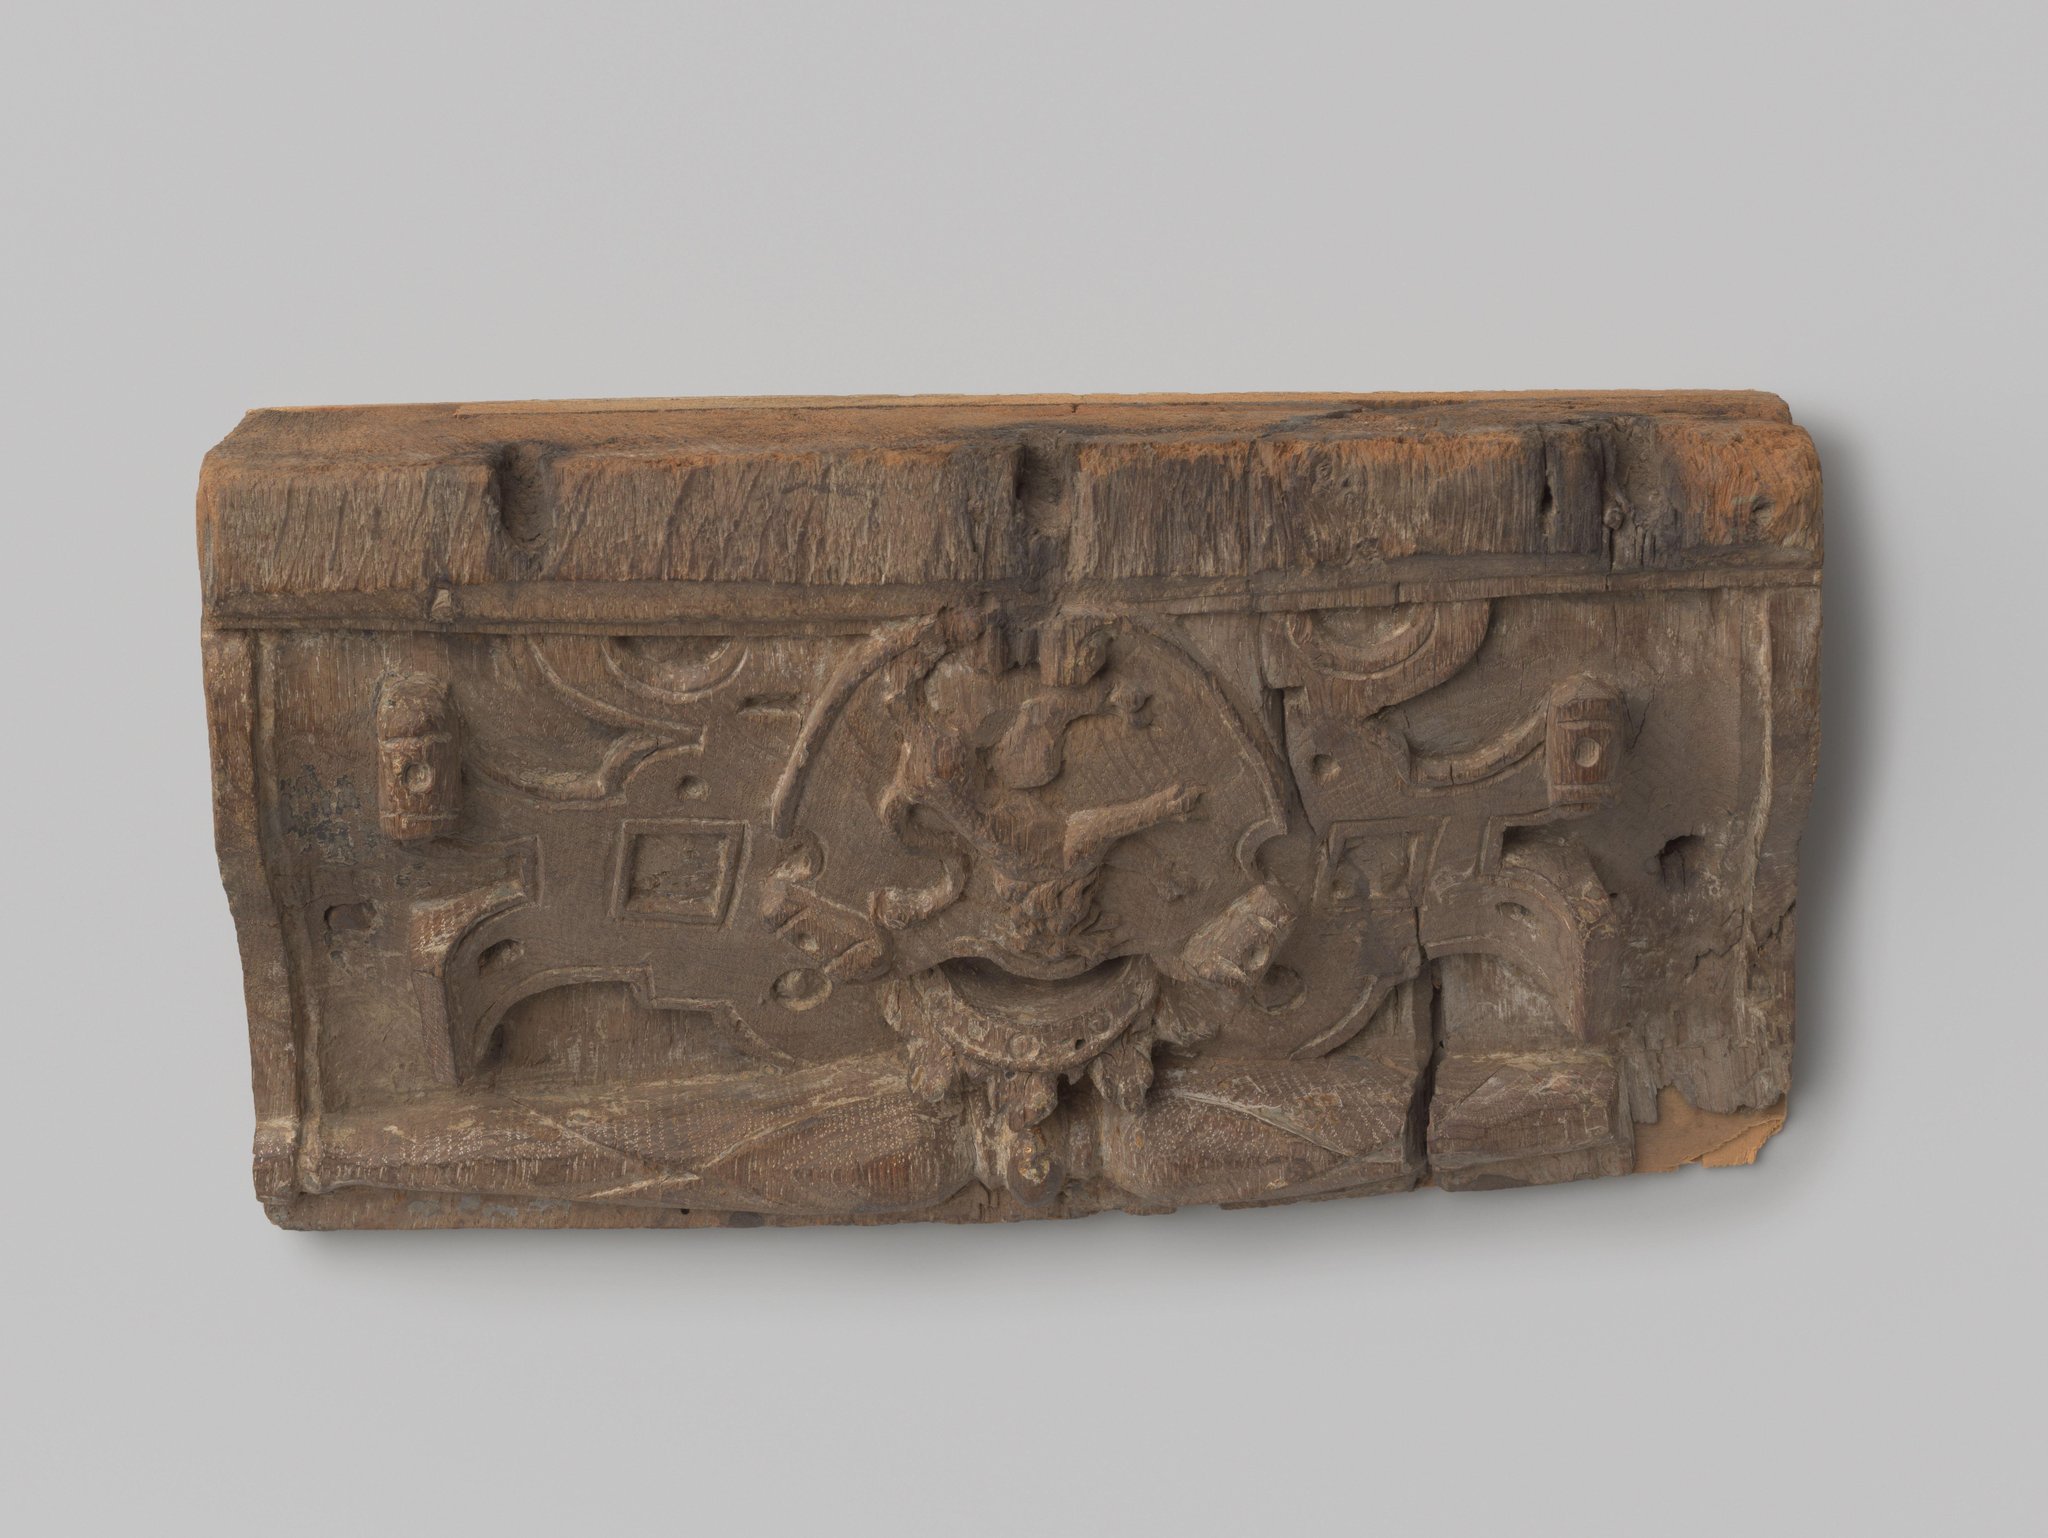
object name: architectural element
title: Sleutelstuk met wapenschild (fragment)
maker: Anonymous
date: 1550-1600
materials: wood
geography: northern netherlands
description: Uiteinde van een sleutelstuk van eikenhout met een wapenschild, Afkomstig uit het afgebroken huis Warmoesstraat 145 te Amsterdam.